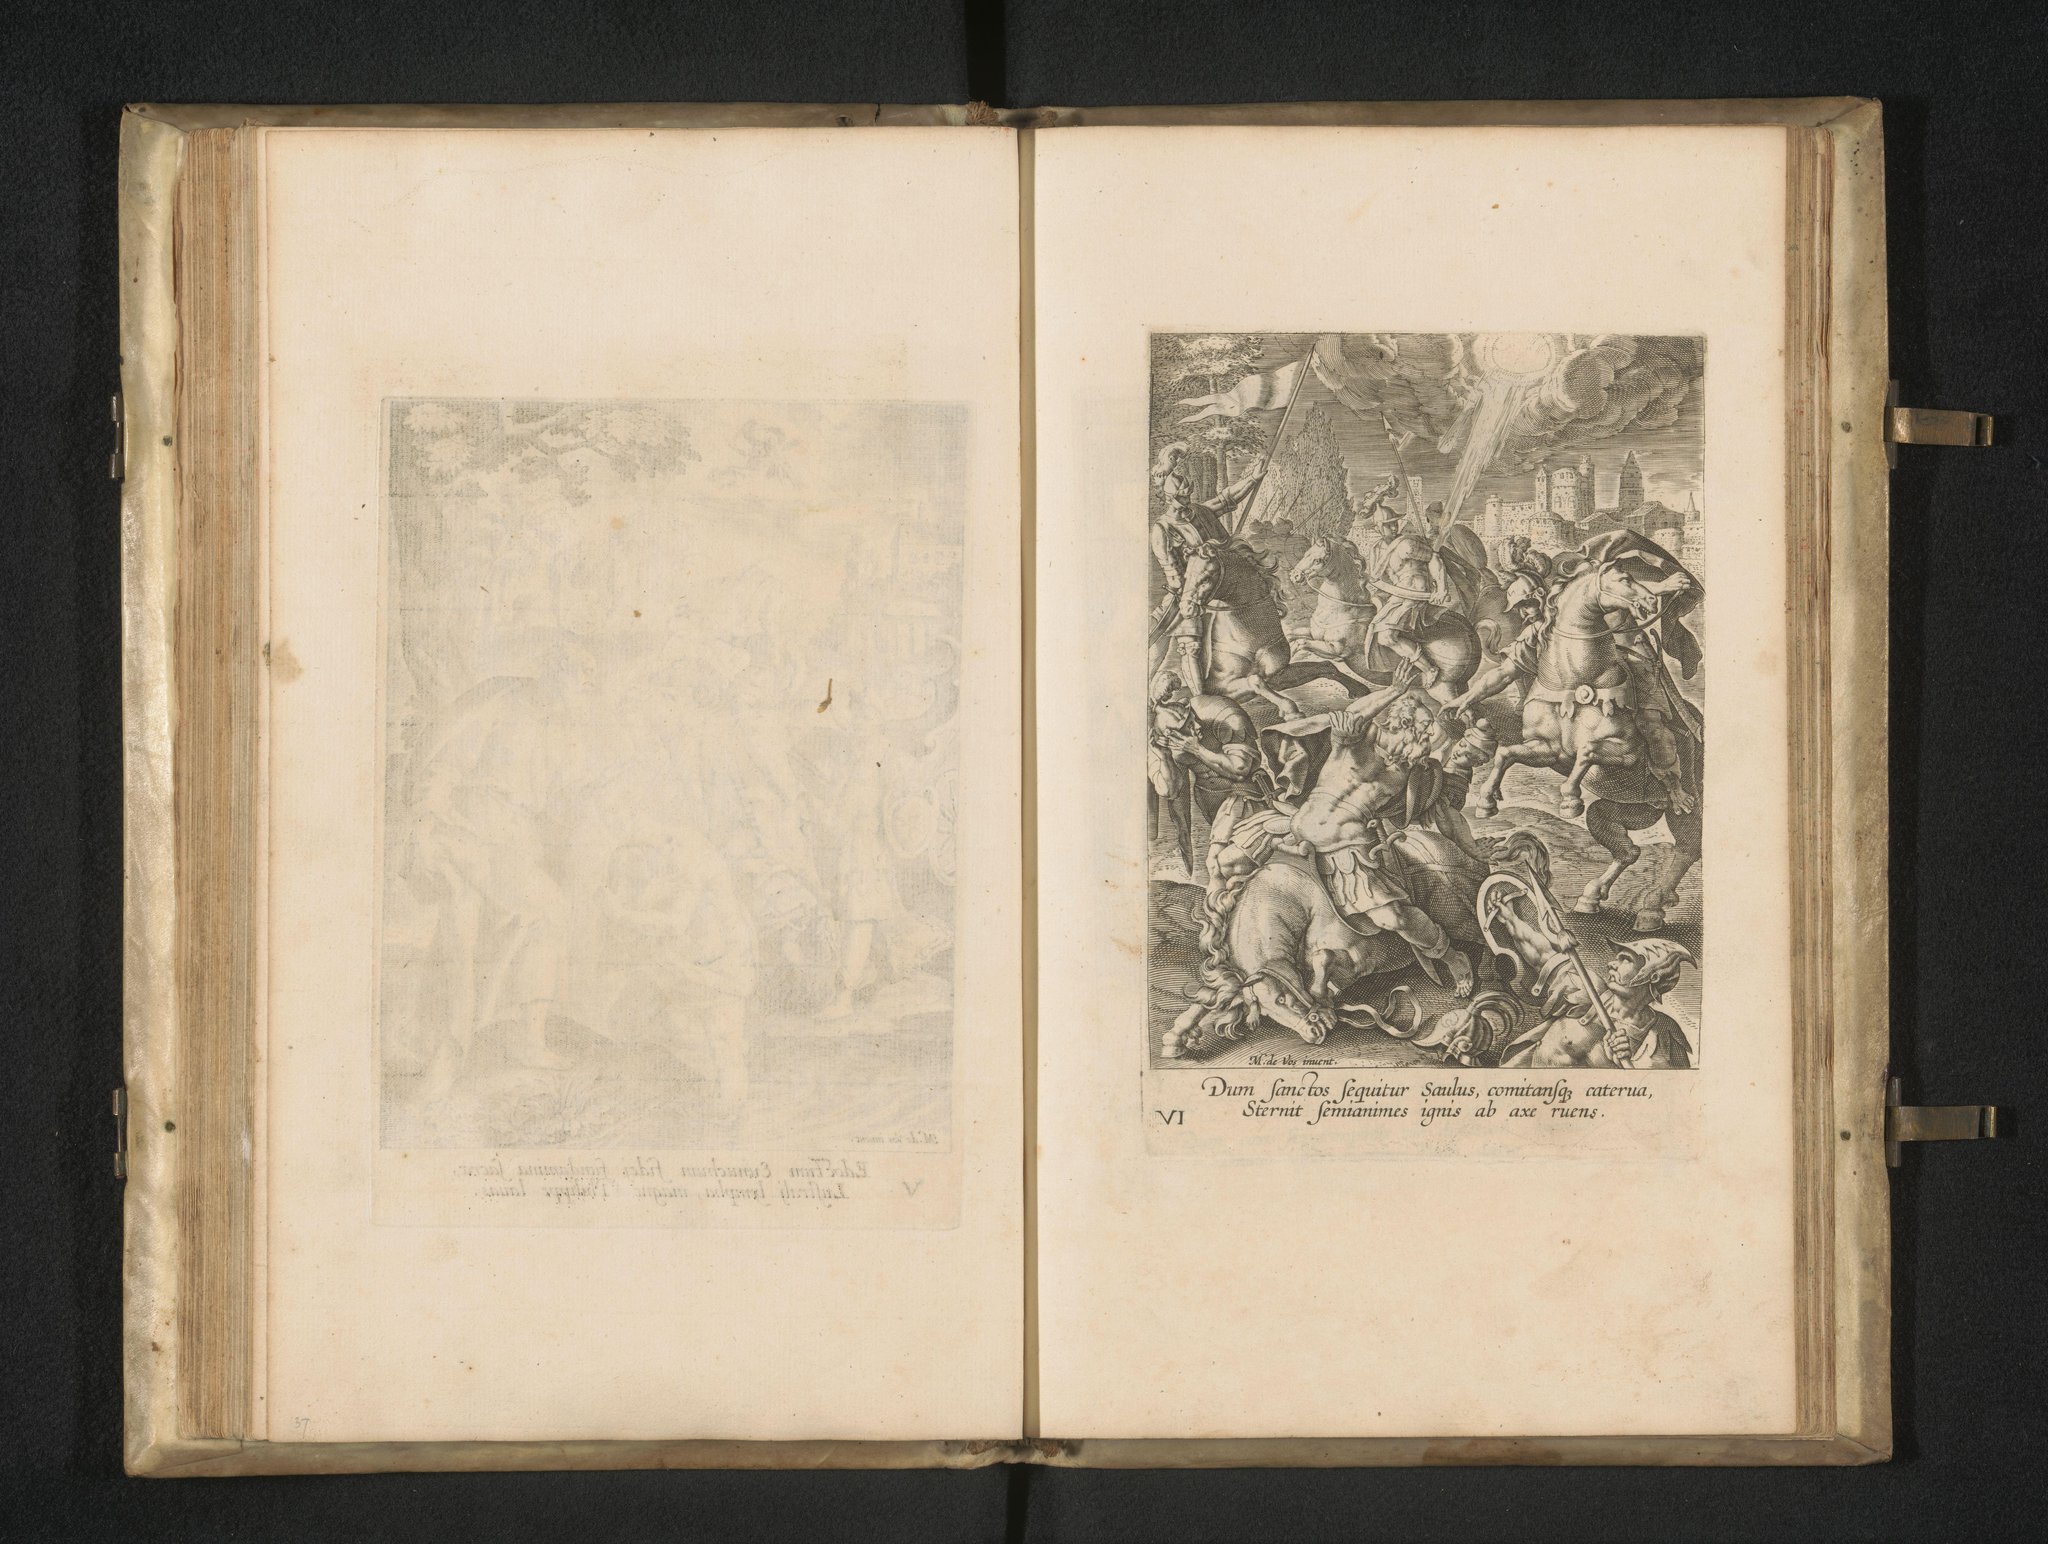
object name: print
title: Handelingen van de apostelen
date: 1580-1585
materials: paper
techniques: engraving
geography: antwerp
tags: on the way to damascus christ appears to saul, who falls from his horse and is blinded by the light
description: Saul, de latere apostel Paulus, wordt onderweg naar Damascus verblind door licht uit de hemel. Linksonder genummerd: VI. Onderaan in de marge een tweeregelig onderschrift in het Latijn. Onderdeel van een serie van twaalf voorstellingen van de Handelingen van de apostelen. Onderdeel van een album met voornamelijk christelijke voorstellingen.